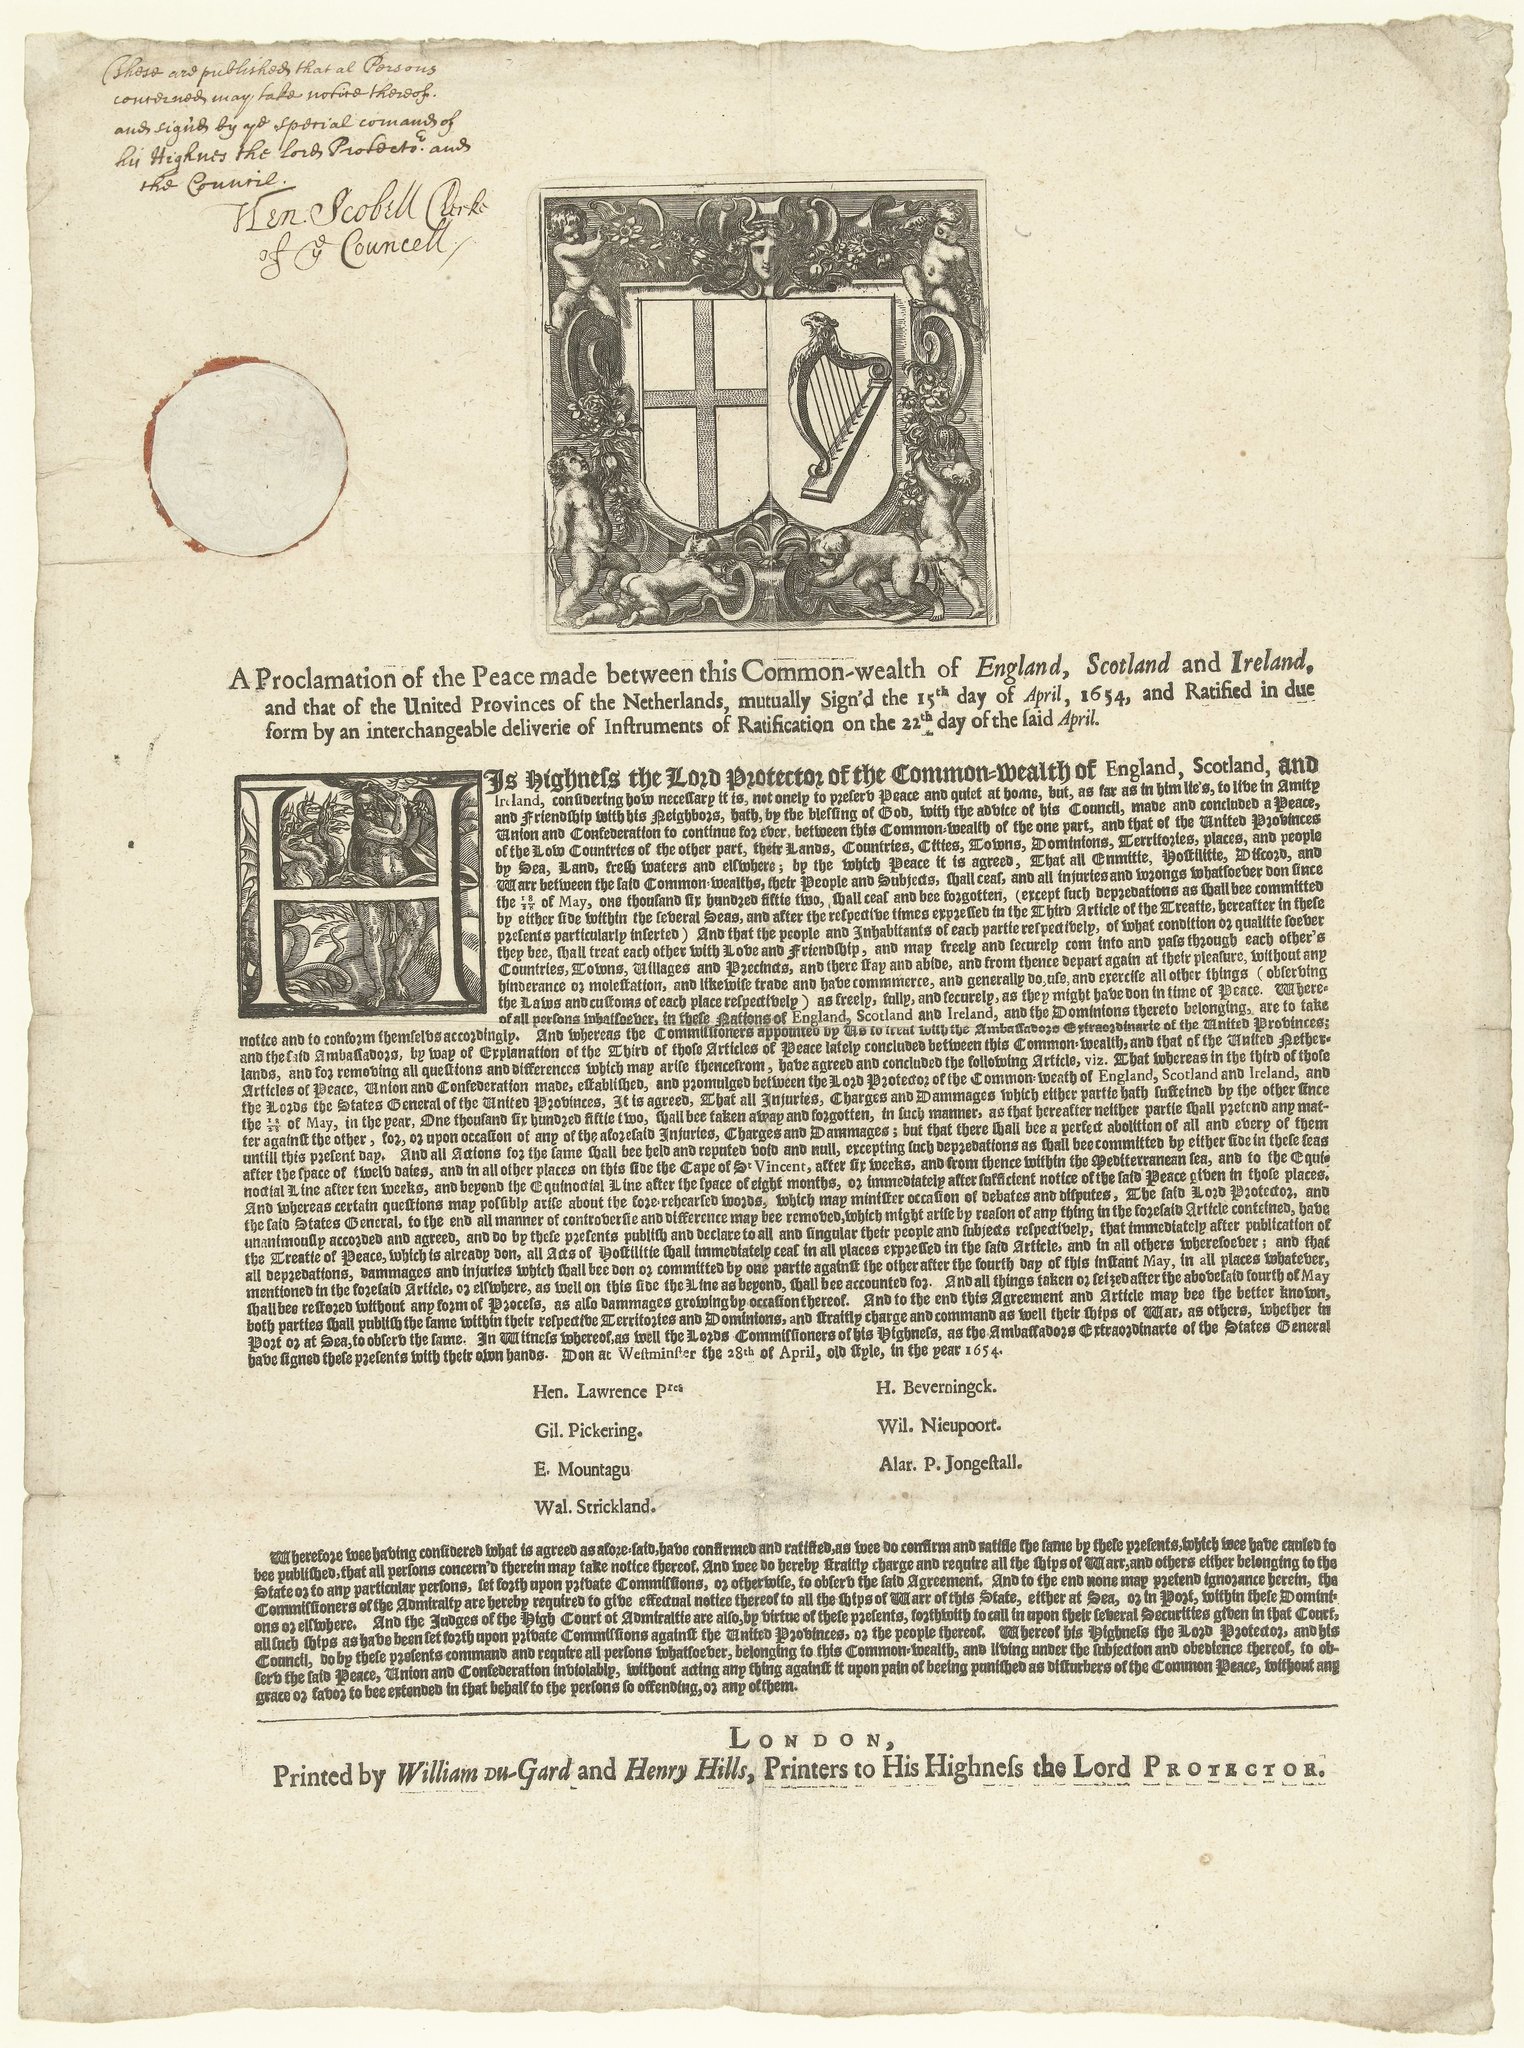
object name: print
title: Officiële proclamatie van de Vrede van Westminster, 15 april 1654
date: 1654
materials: paper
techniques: etching, letterpress printing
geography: london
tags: westminster, vrede van westminster (1654)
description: Officiële proclamatie van de Vrede van Westminster, gesloten op 15 april 1654 tussen Verenigde Provincies en Engeland, waarmee een einde komt aan de Eerste Engelse Oorlog. Blad met een afdruk van een plaat met de wapens van Engeland en Ierland, tekst in het Engels beginnend met een versierde initiaal H (Hercules), lakzegel met de wapens van Engeland en Ierland en een annotatie van H. Scobell, clerk of the Council.